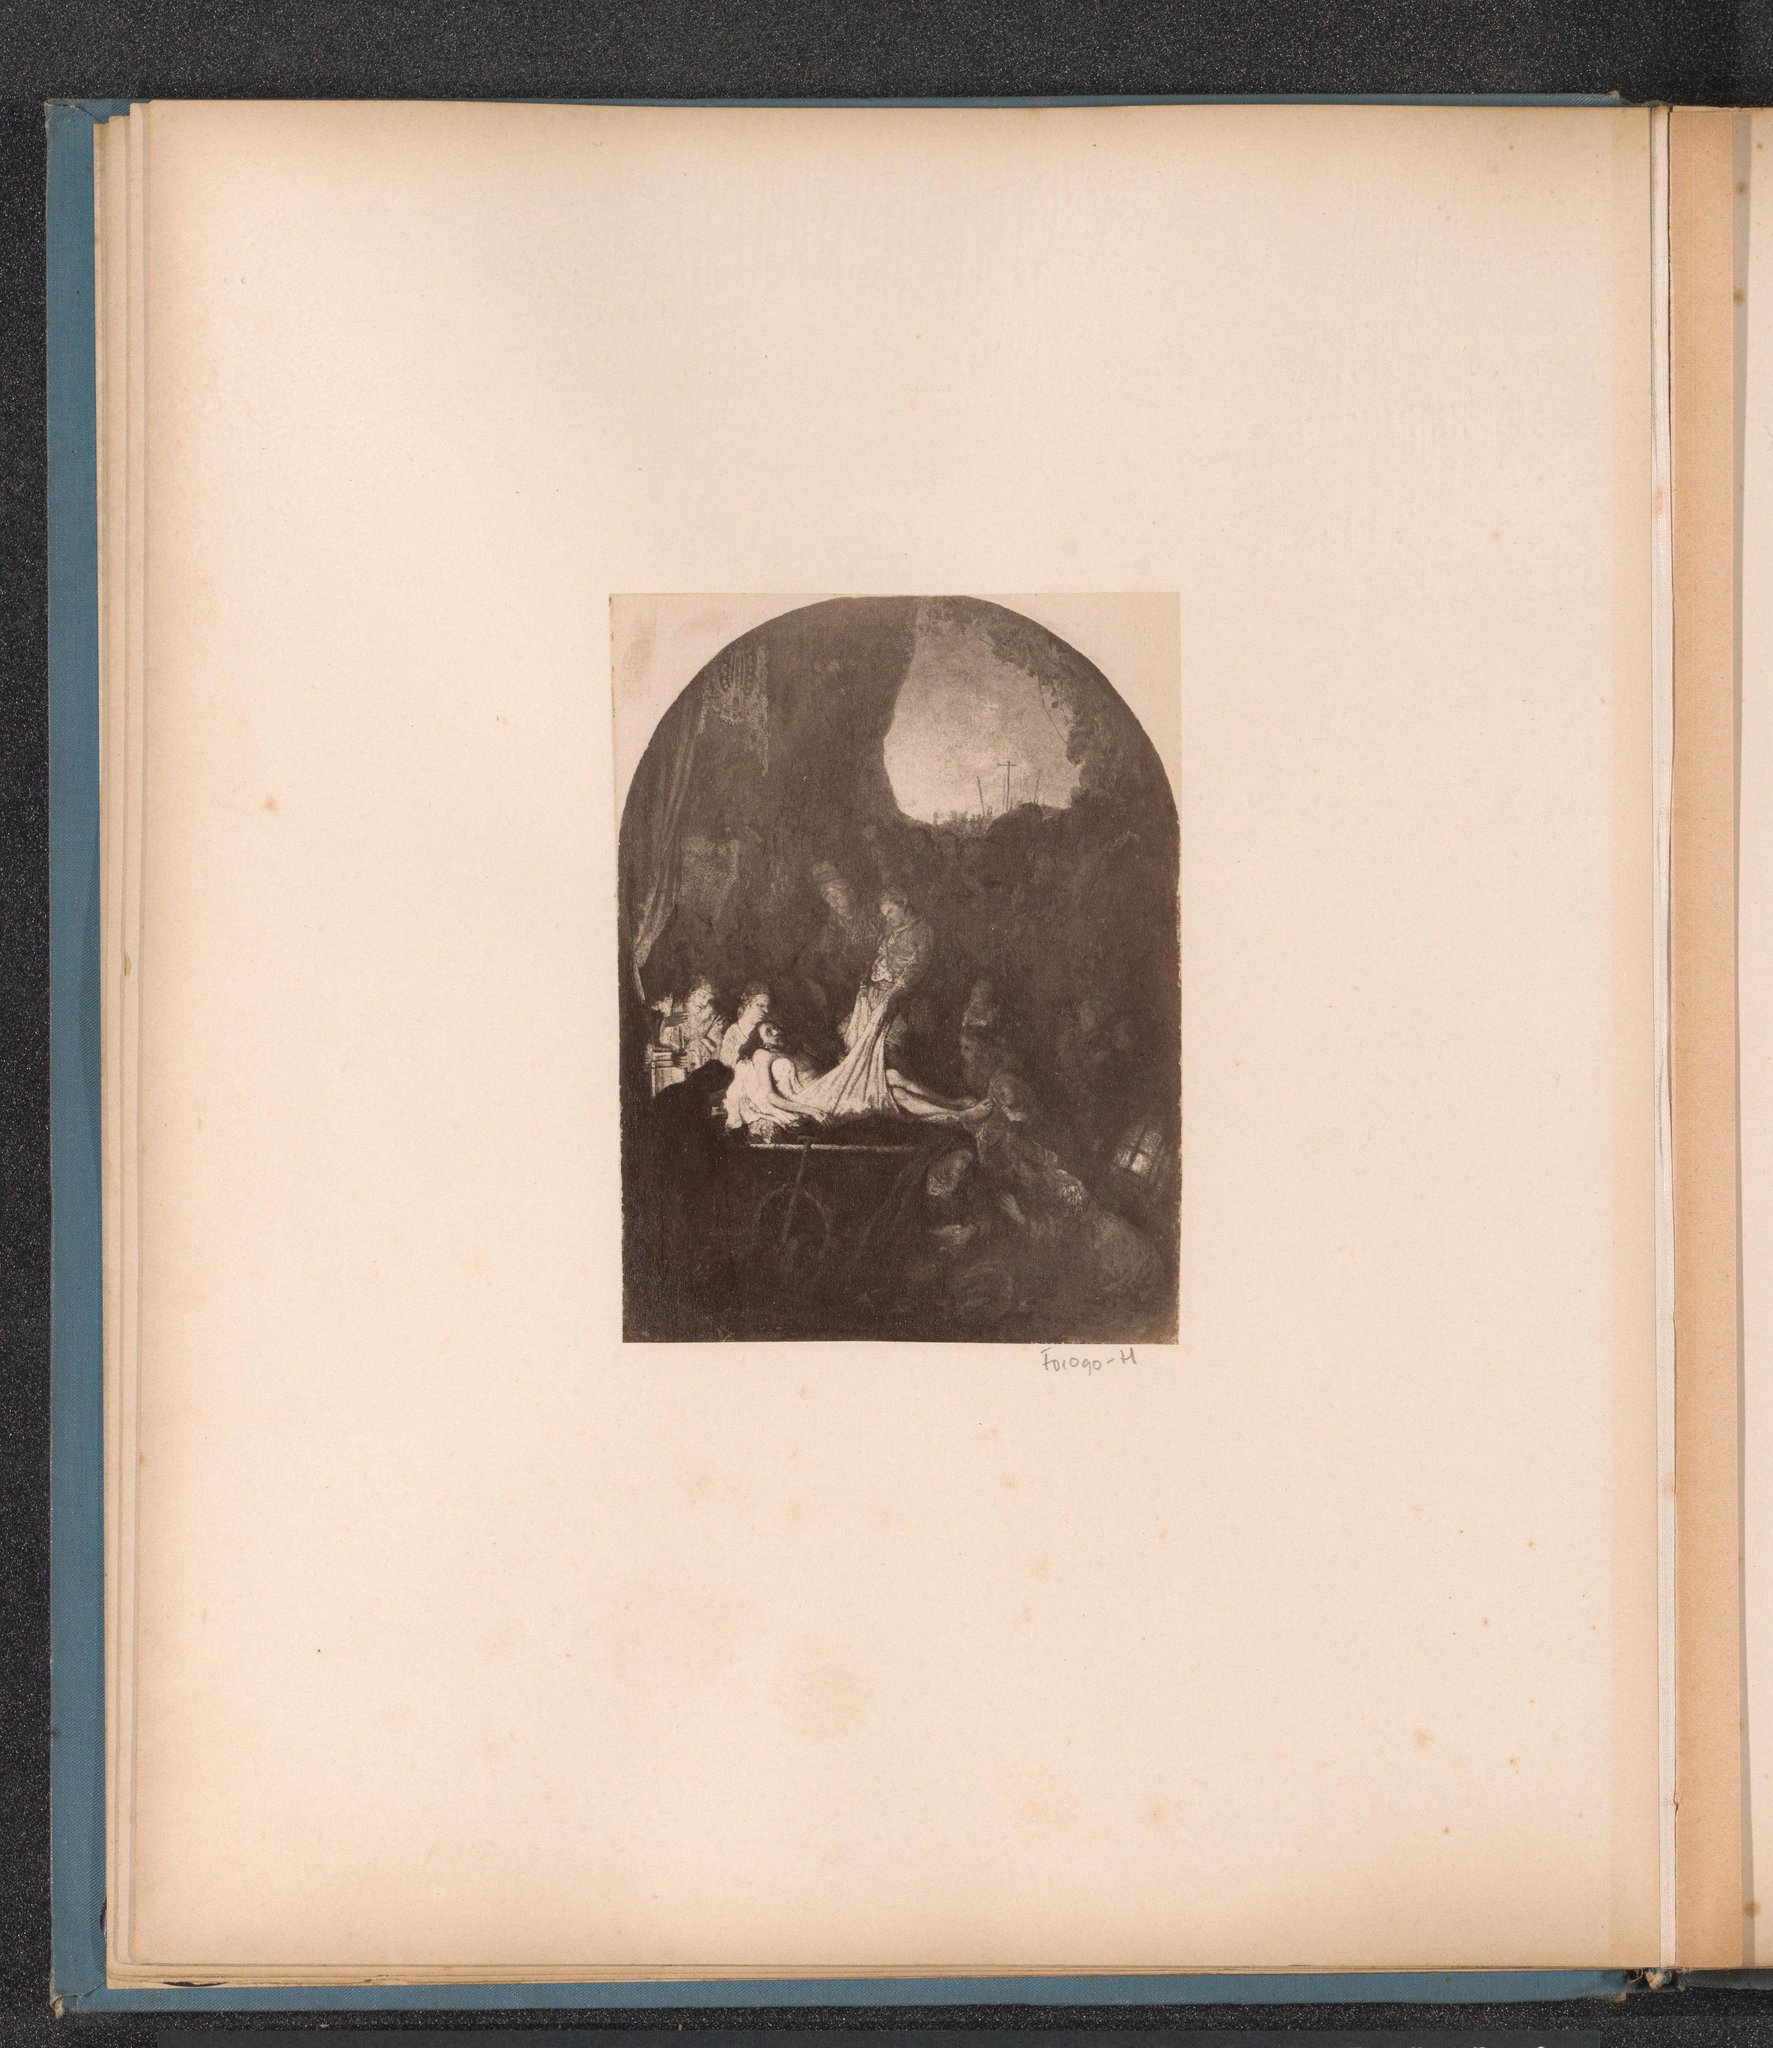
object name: reproduction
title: Fotoreproductie van (vermoedelijk) een prent naar een schilderij door Rembrandt, voorstellend de graflegging van Christus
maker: Anonymous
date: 1870-1900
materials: paper, photographic support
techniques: albumen print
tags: christ's entombment (possibly by angels)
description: Onderdeel van Reisalbum met foto's van bezienswaardigheden in Duitsland en Oostenrijk en van kunstwerken.